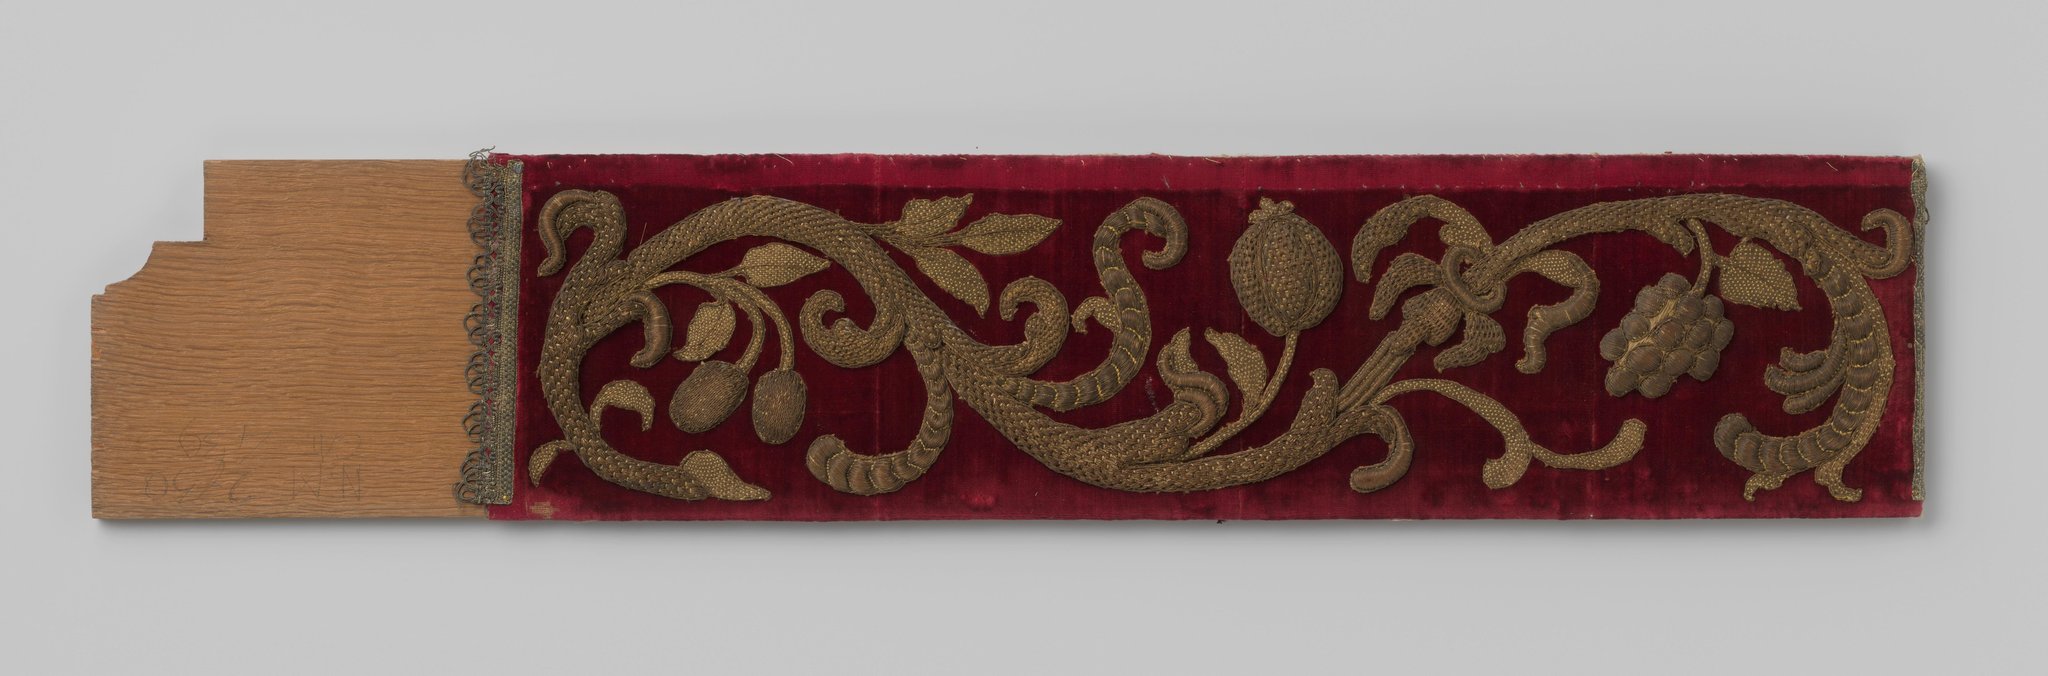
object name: strip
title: Strook met borduurwerk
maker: Anonymous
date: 1700-1725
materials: gold thread, velvet, wood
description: Strook met gouden borduurwerk op karmozijnrode, fluwelen grond. Op raam gezet.